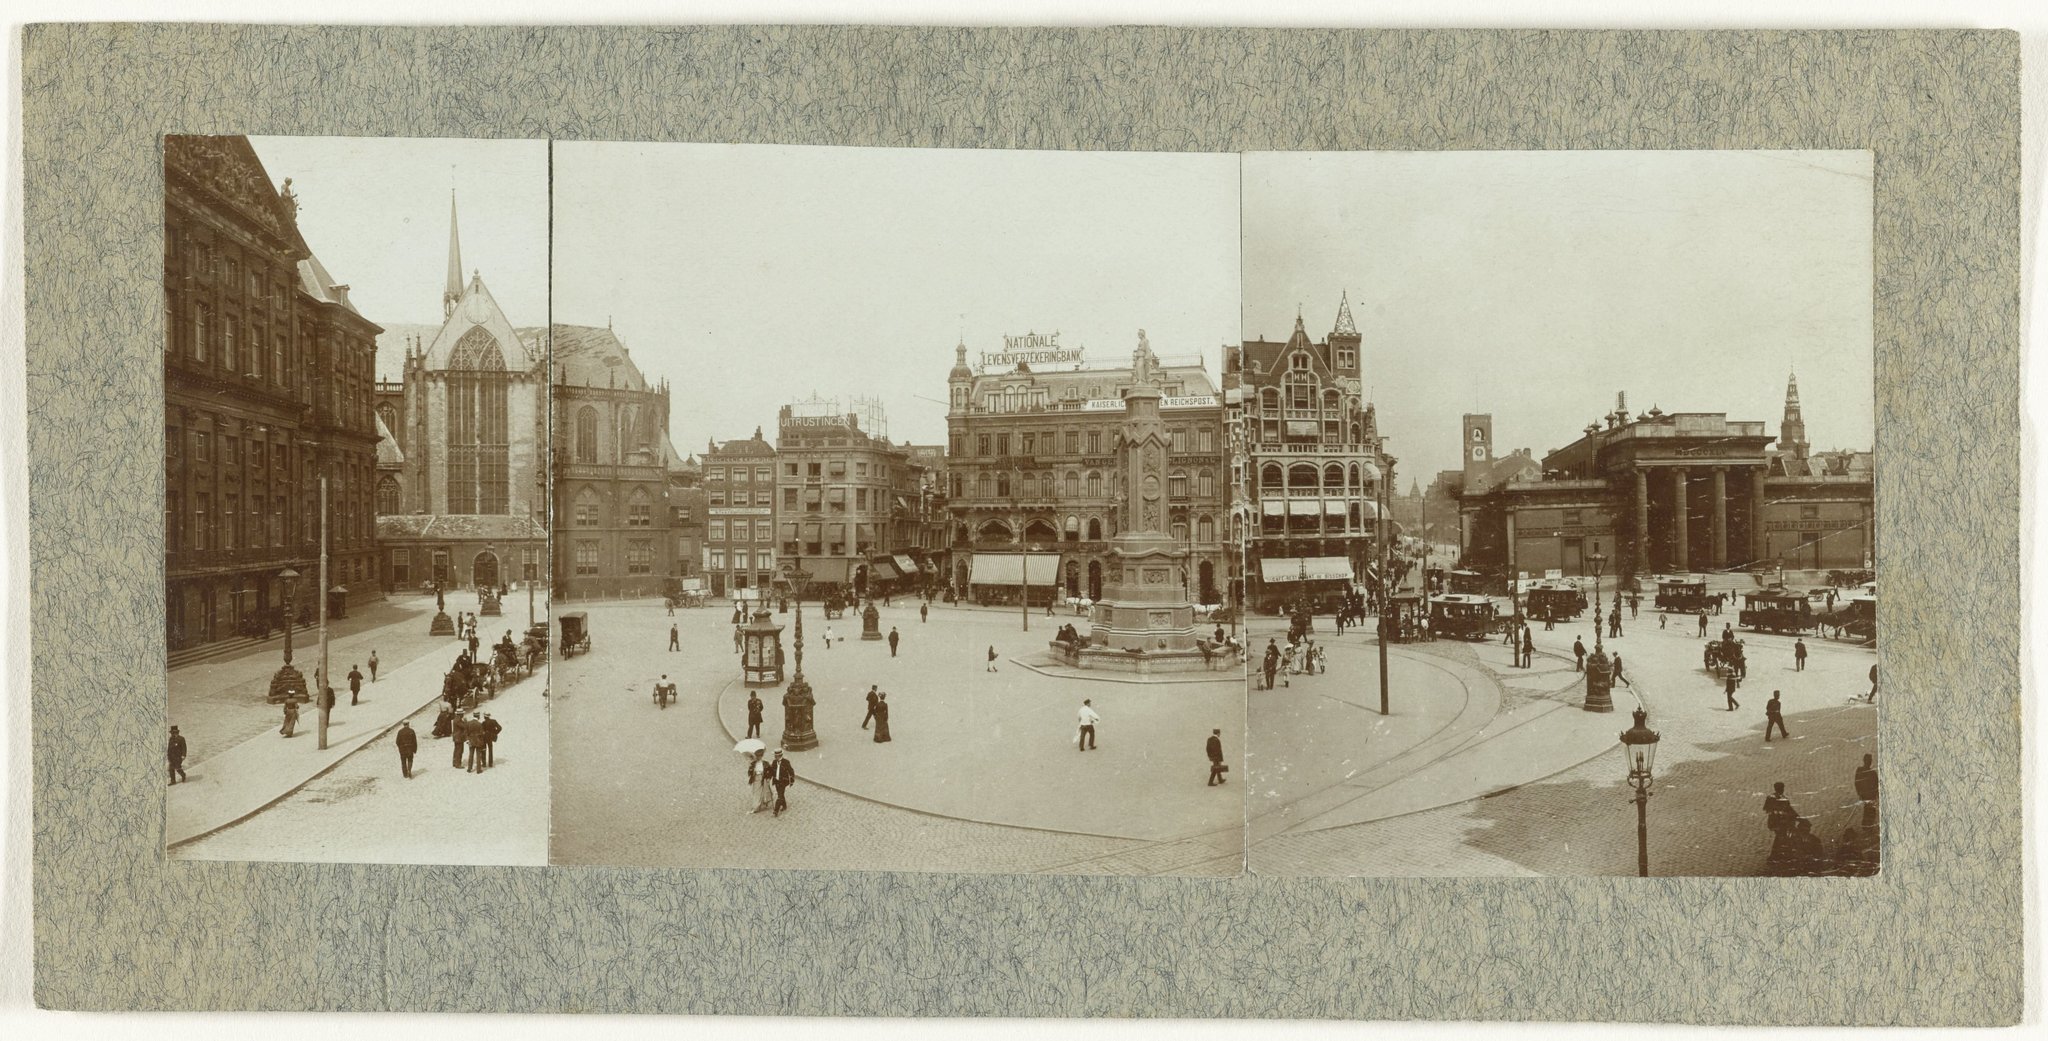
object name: photograph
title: Panorama of Dam Square in Amsterdam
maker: Anonymous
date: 1899-1903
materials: cardboard, paper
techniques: gelatin silver print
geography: netherlands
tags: square, place, circus, etc.